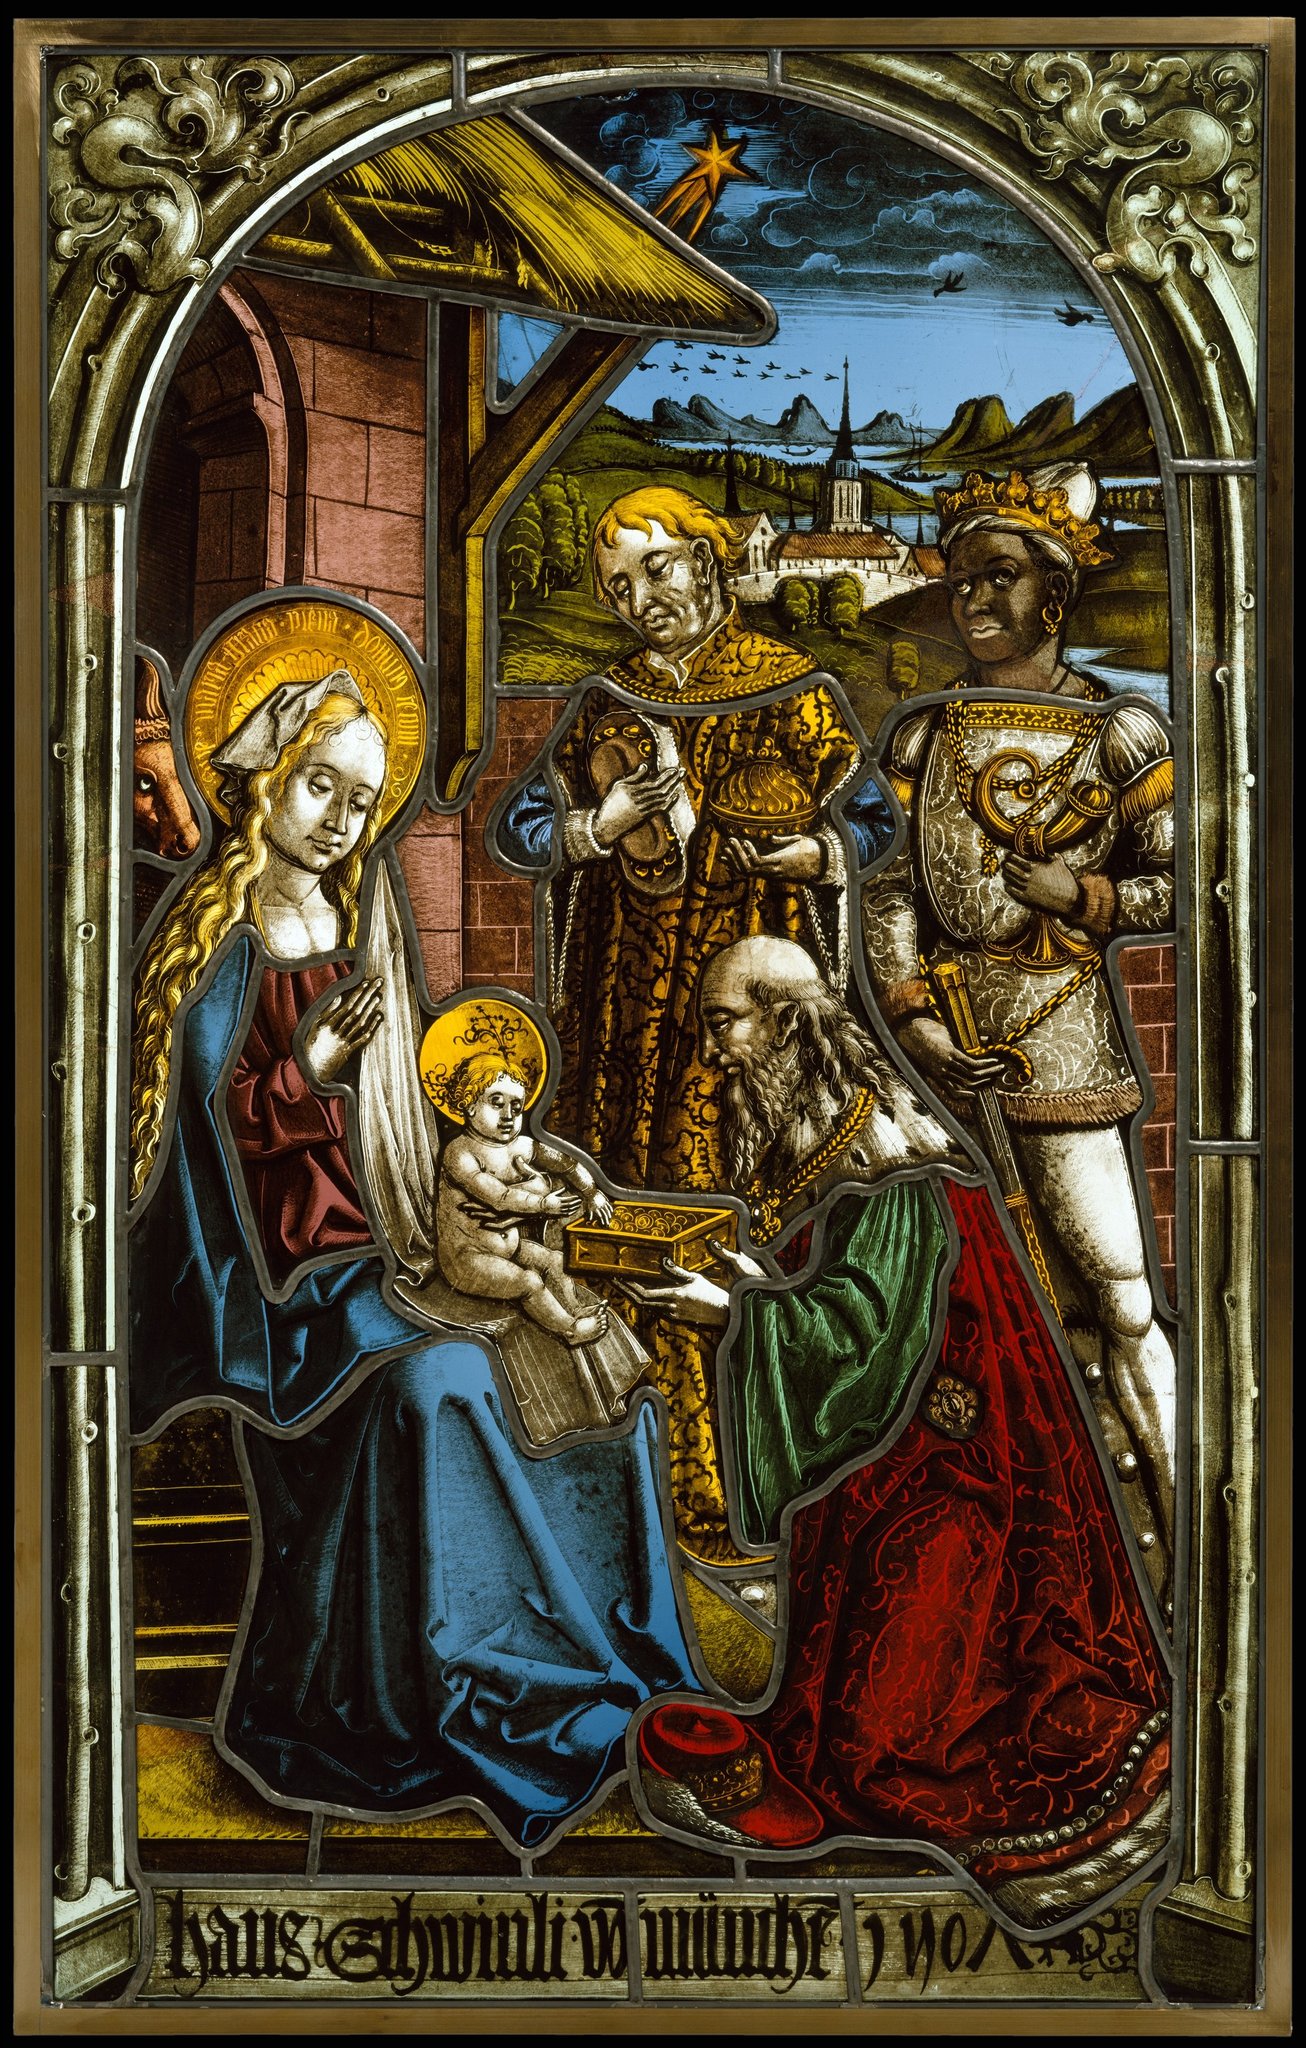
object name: panel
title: Adoration of the Magi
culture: german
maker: circle of peter hemmel von andlau (strassburger werkstattgemeinschaft)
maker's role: artist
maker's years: 1470-1500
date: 1507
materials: glass, metal, paint, pigment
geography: germany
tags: virgin mary,jesus,adoration of the magi